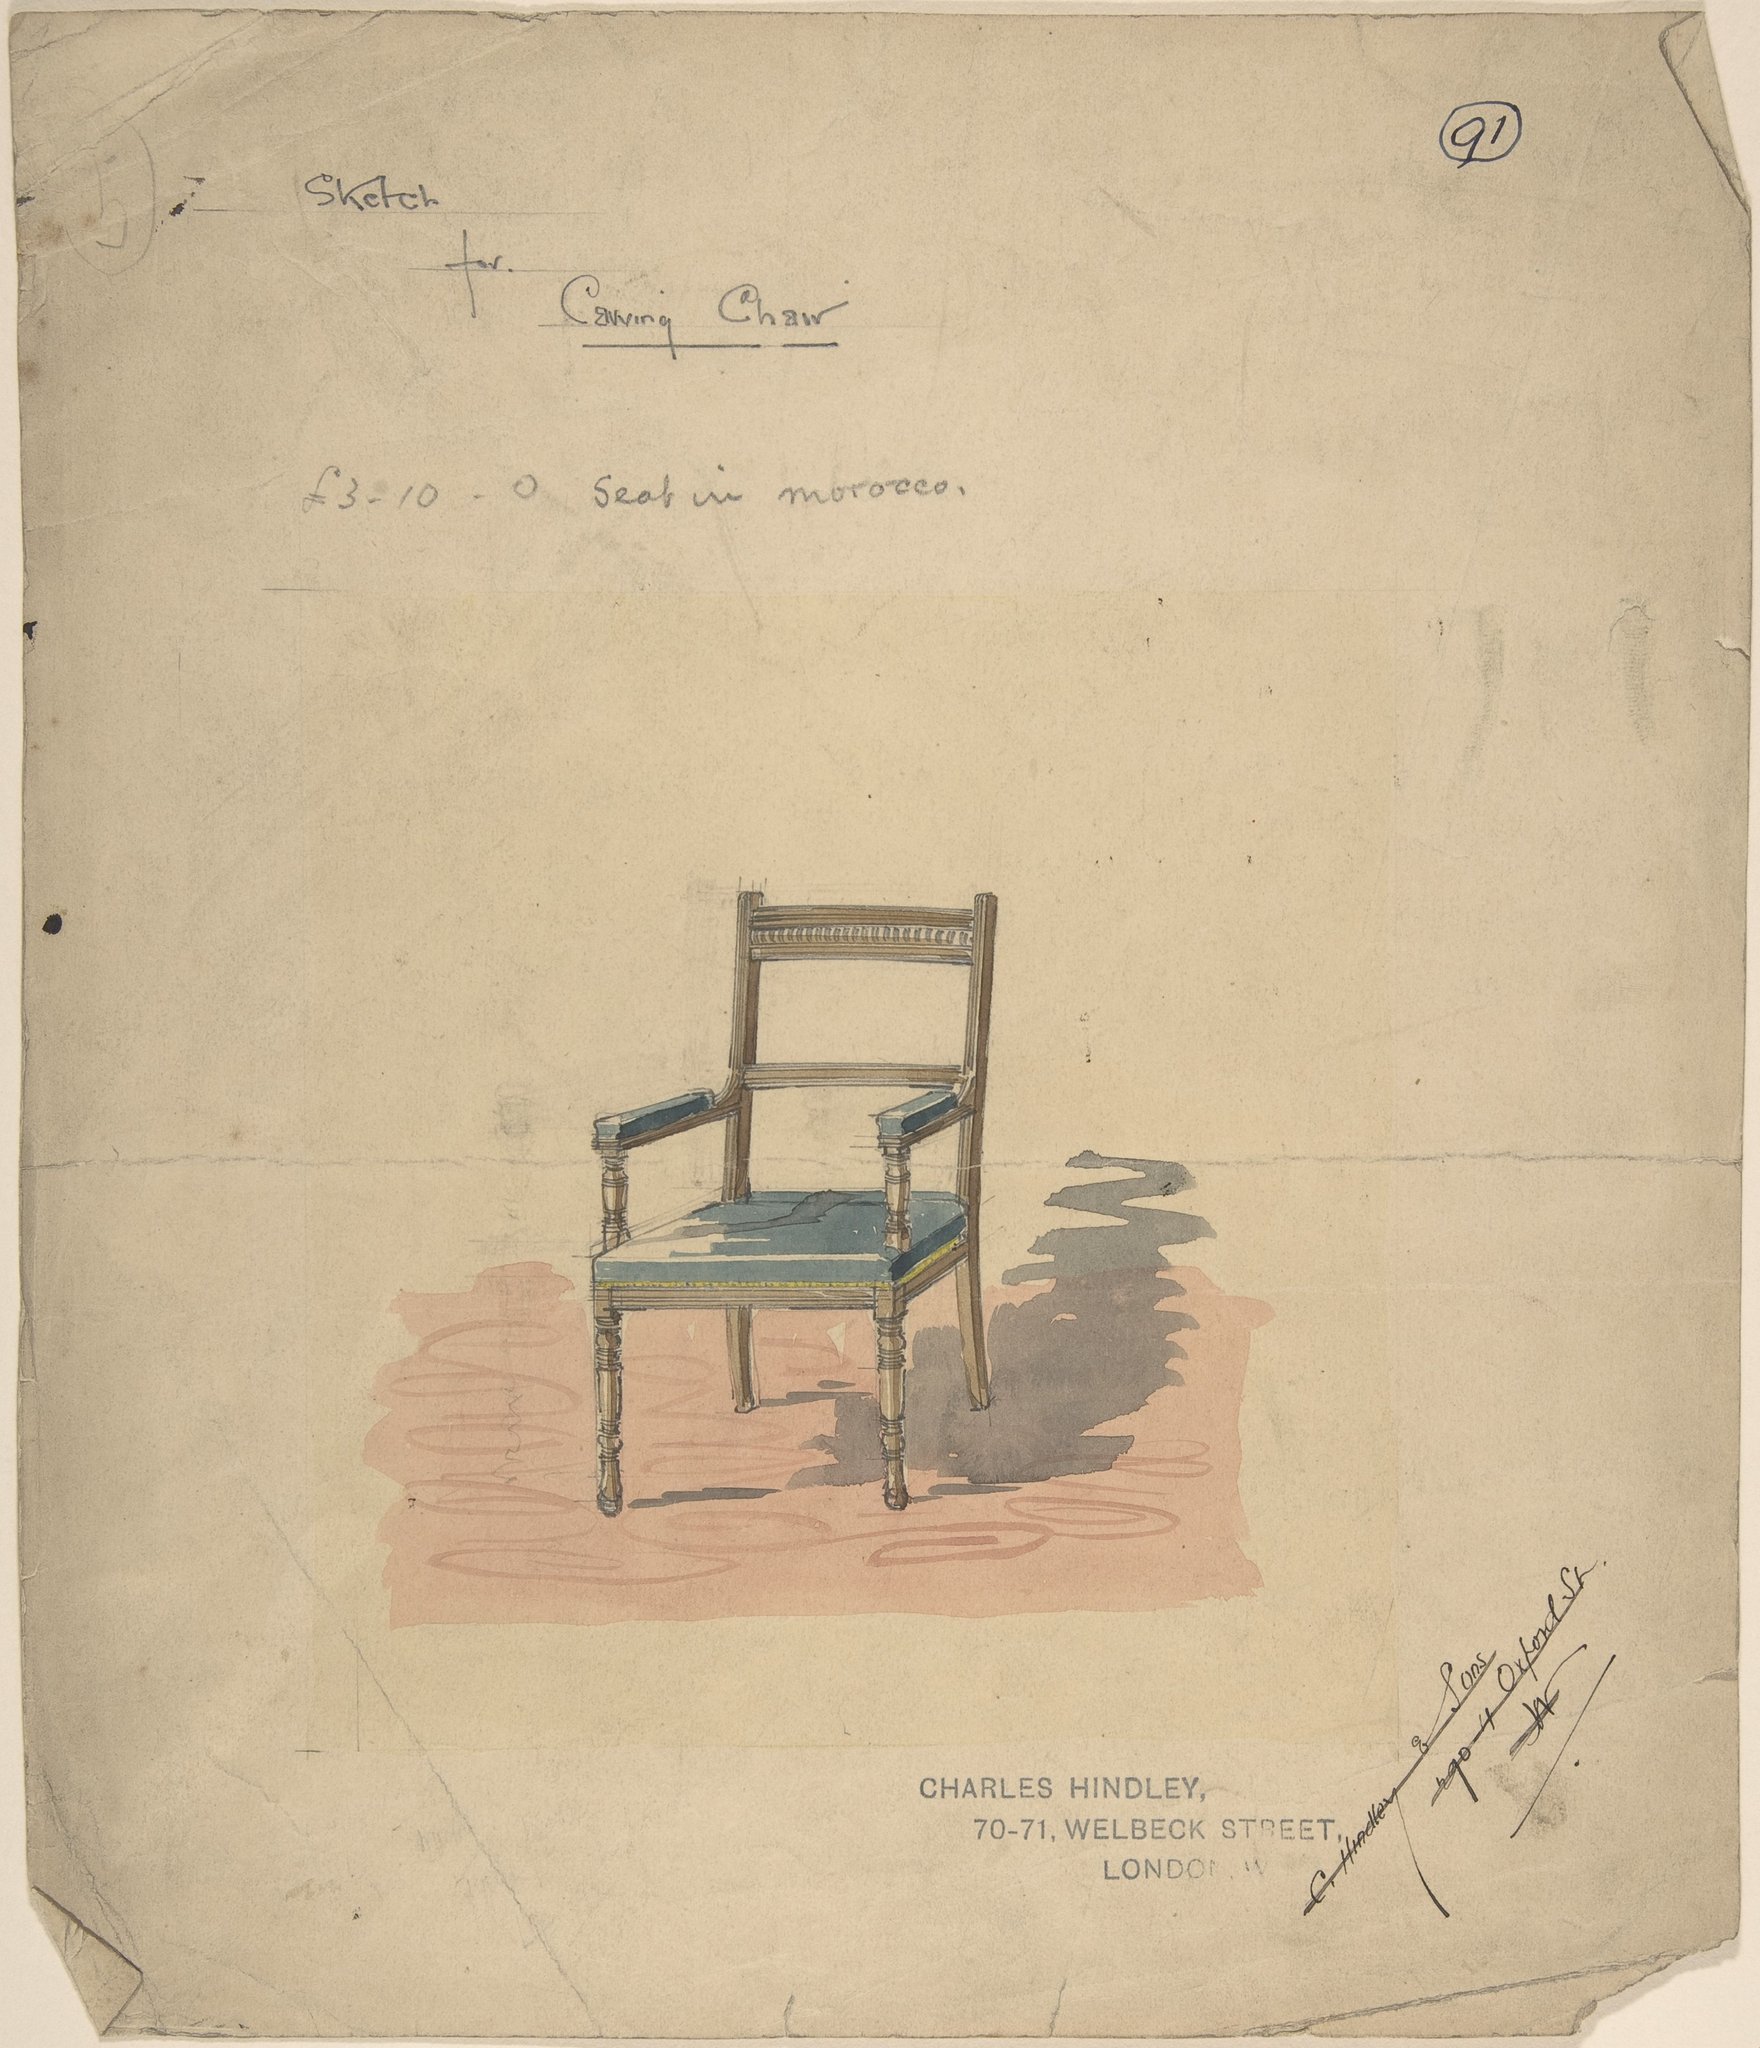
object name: drawing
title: Design of a Carving Chair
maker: charles hindley and sons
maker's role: artist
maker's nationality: british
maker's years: 1841-1917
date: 1884-1892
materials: graphite, watercolor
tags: chairs